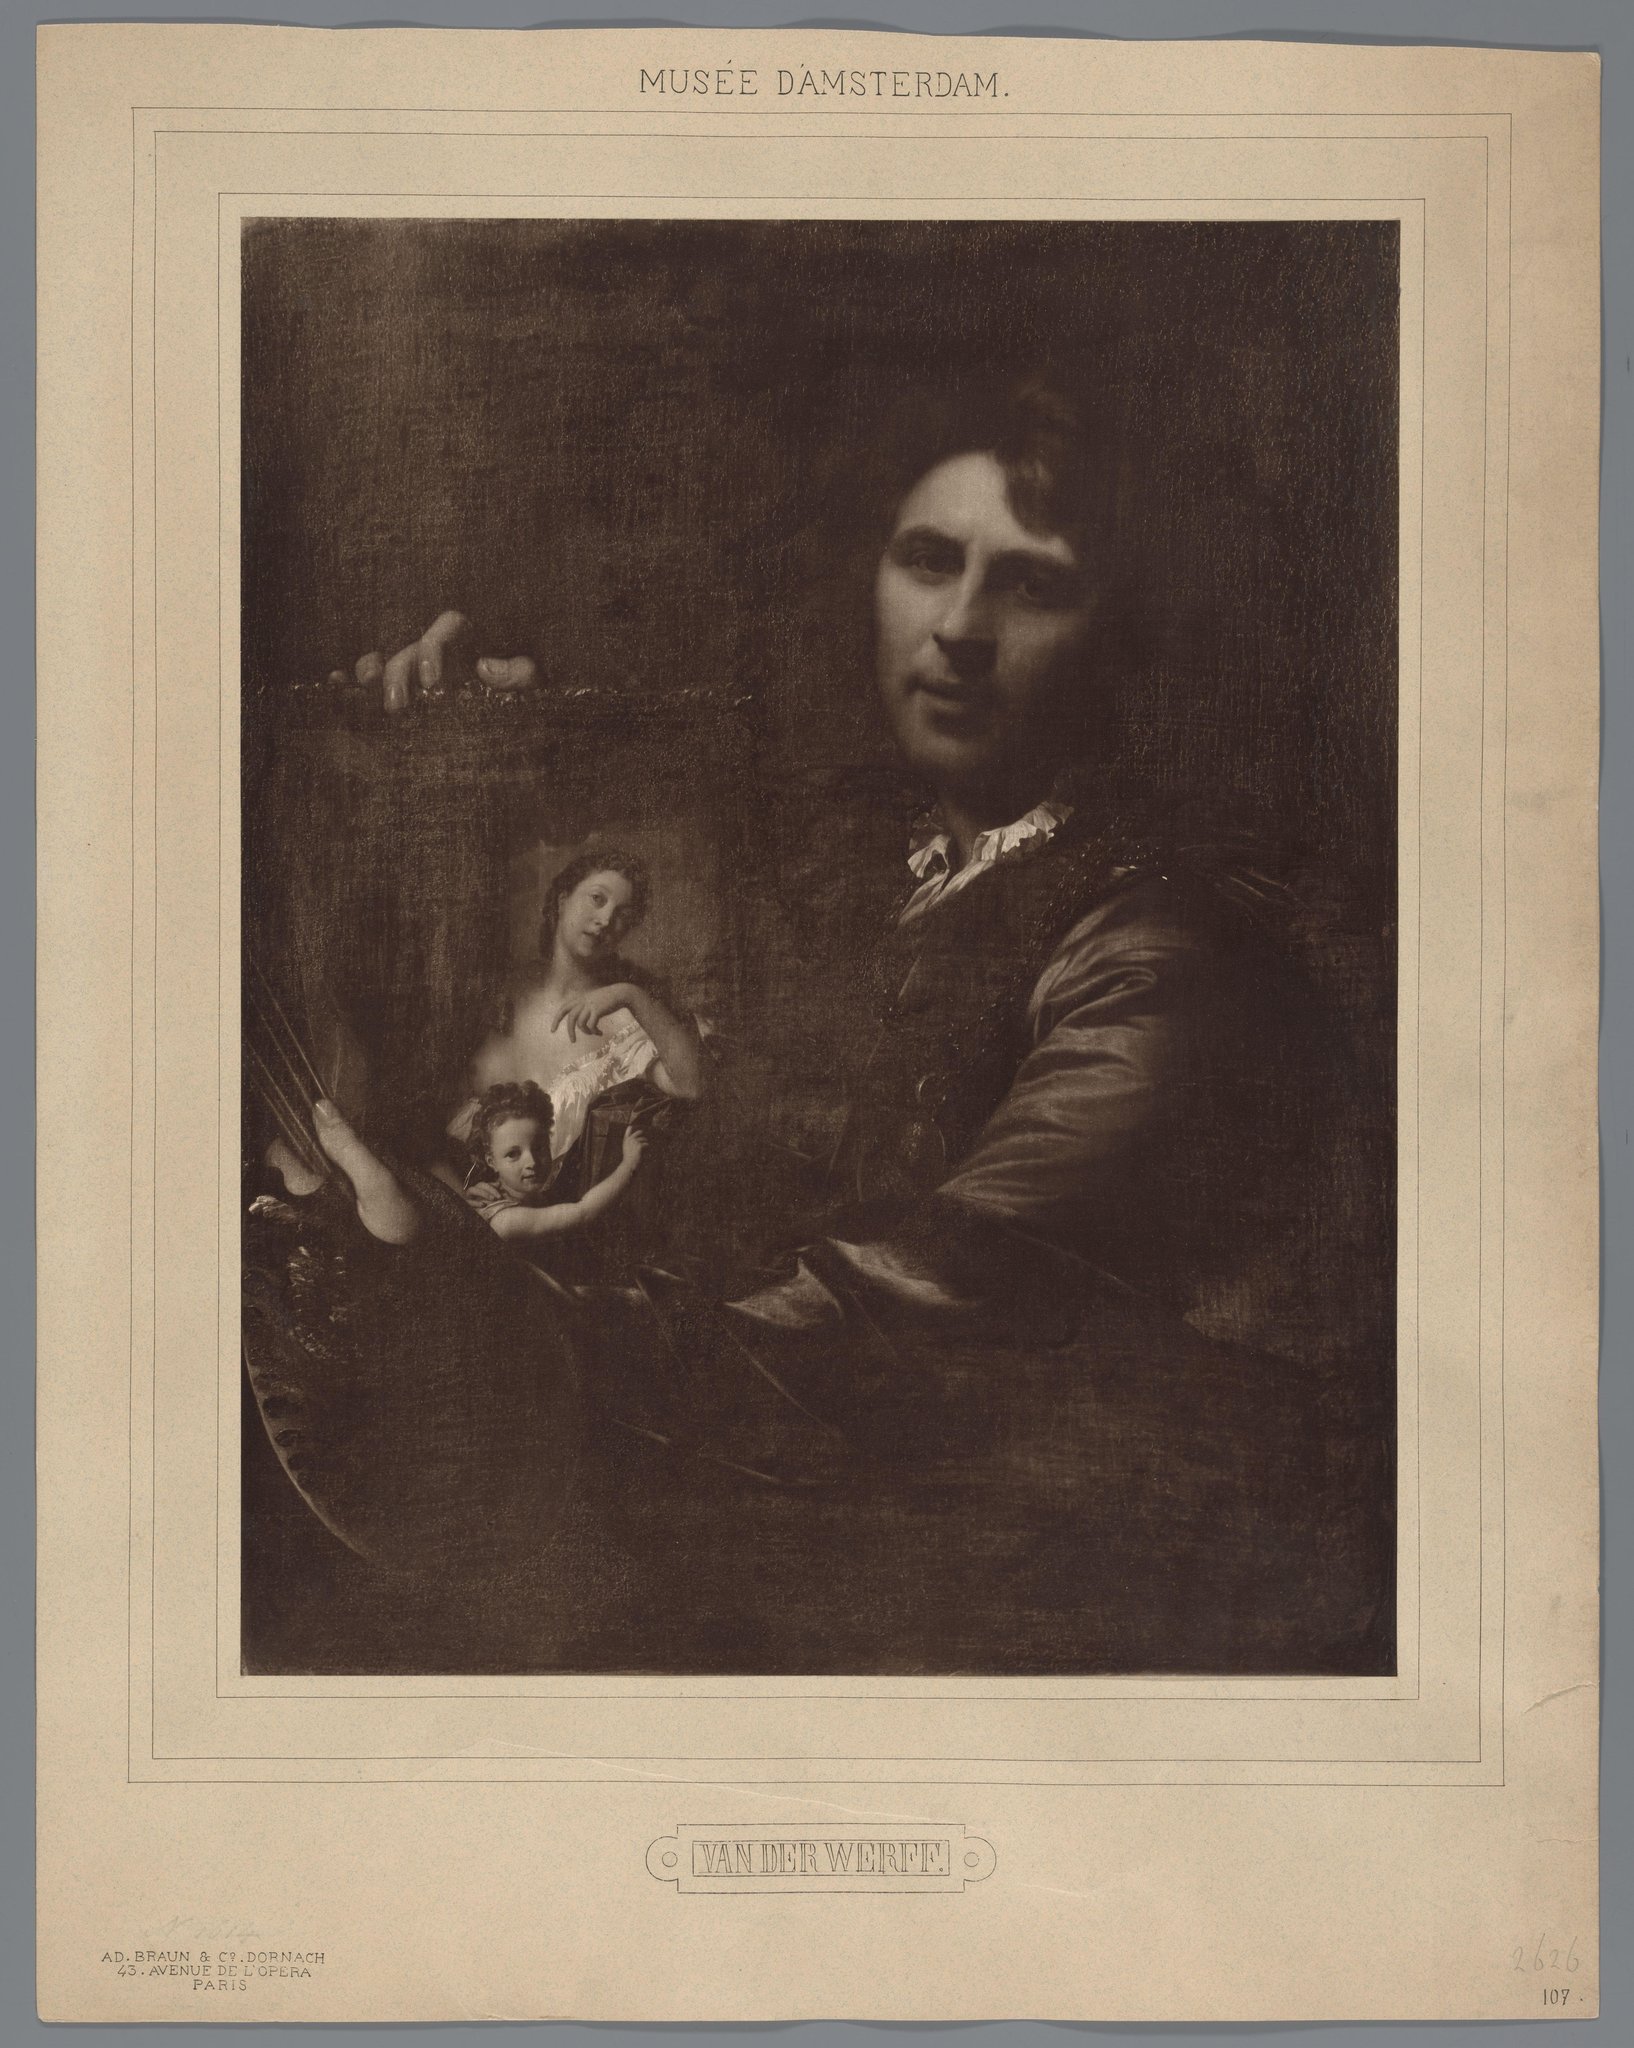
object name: photograph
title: Fotoreproductie van een schilderij van Adriaen van der Werff, 'Zelfportret met het portret van zijn vrouw Margaretha van Rees en hun dochtertje Maria' (coll. Rijksmuseum)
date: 1880-1900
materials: cardboard, paper, photographic support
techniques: carbon print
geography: netherlands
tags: kralingen-ambacht, rotterdam, print maker, adriaen van der werff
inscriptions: annotation: ‘F. 13 / A / 31/3 08’